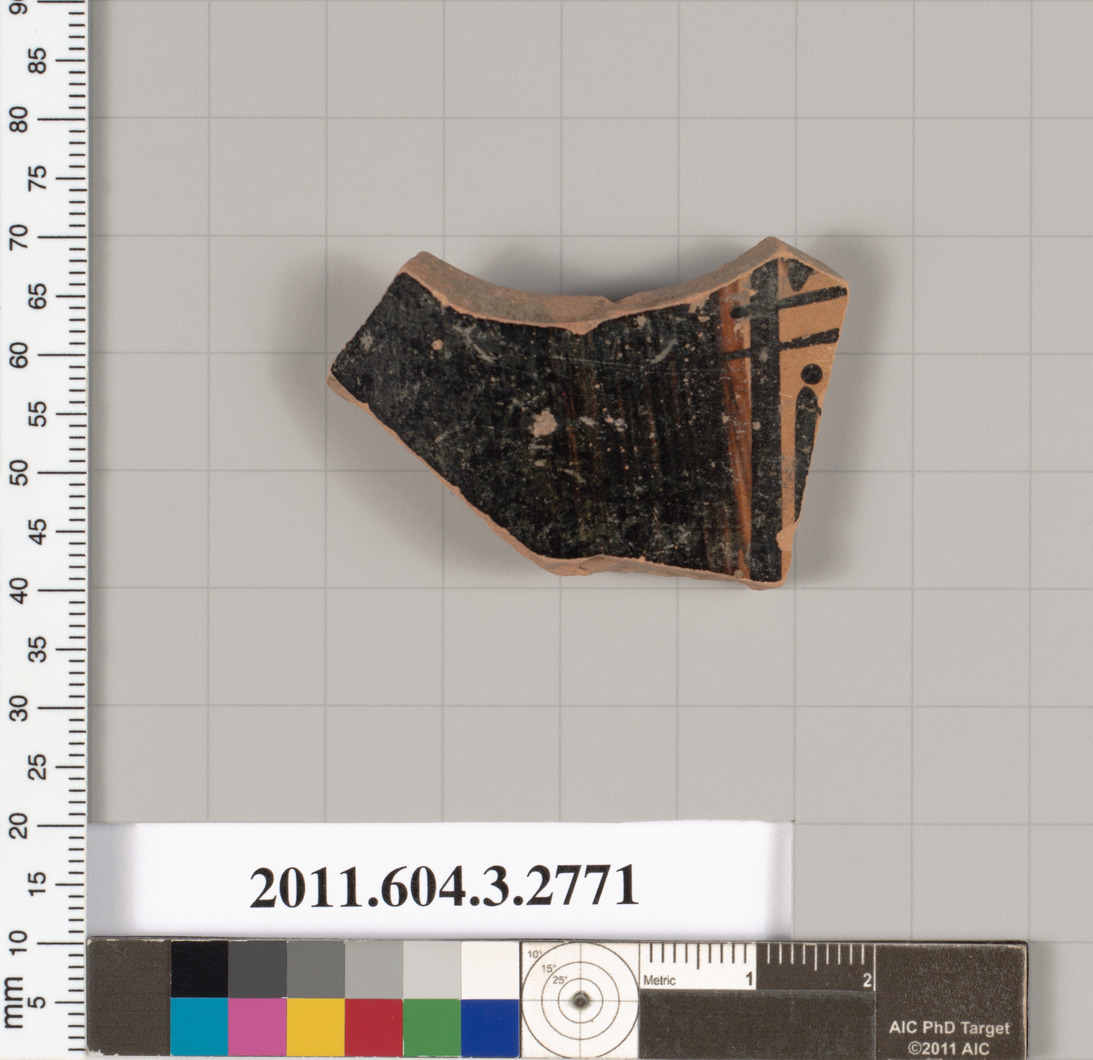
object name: olpe fragment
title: Terracotta fragment of an olpe (jug)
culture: greek, attic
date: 534-468 BCE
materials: terracotta